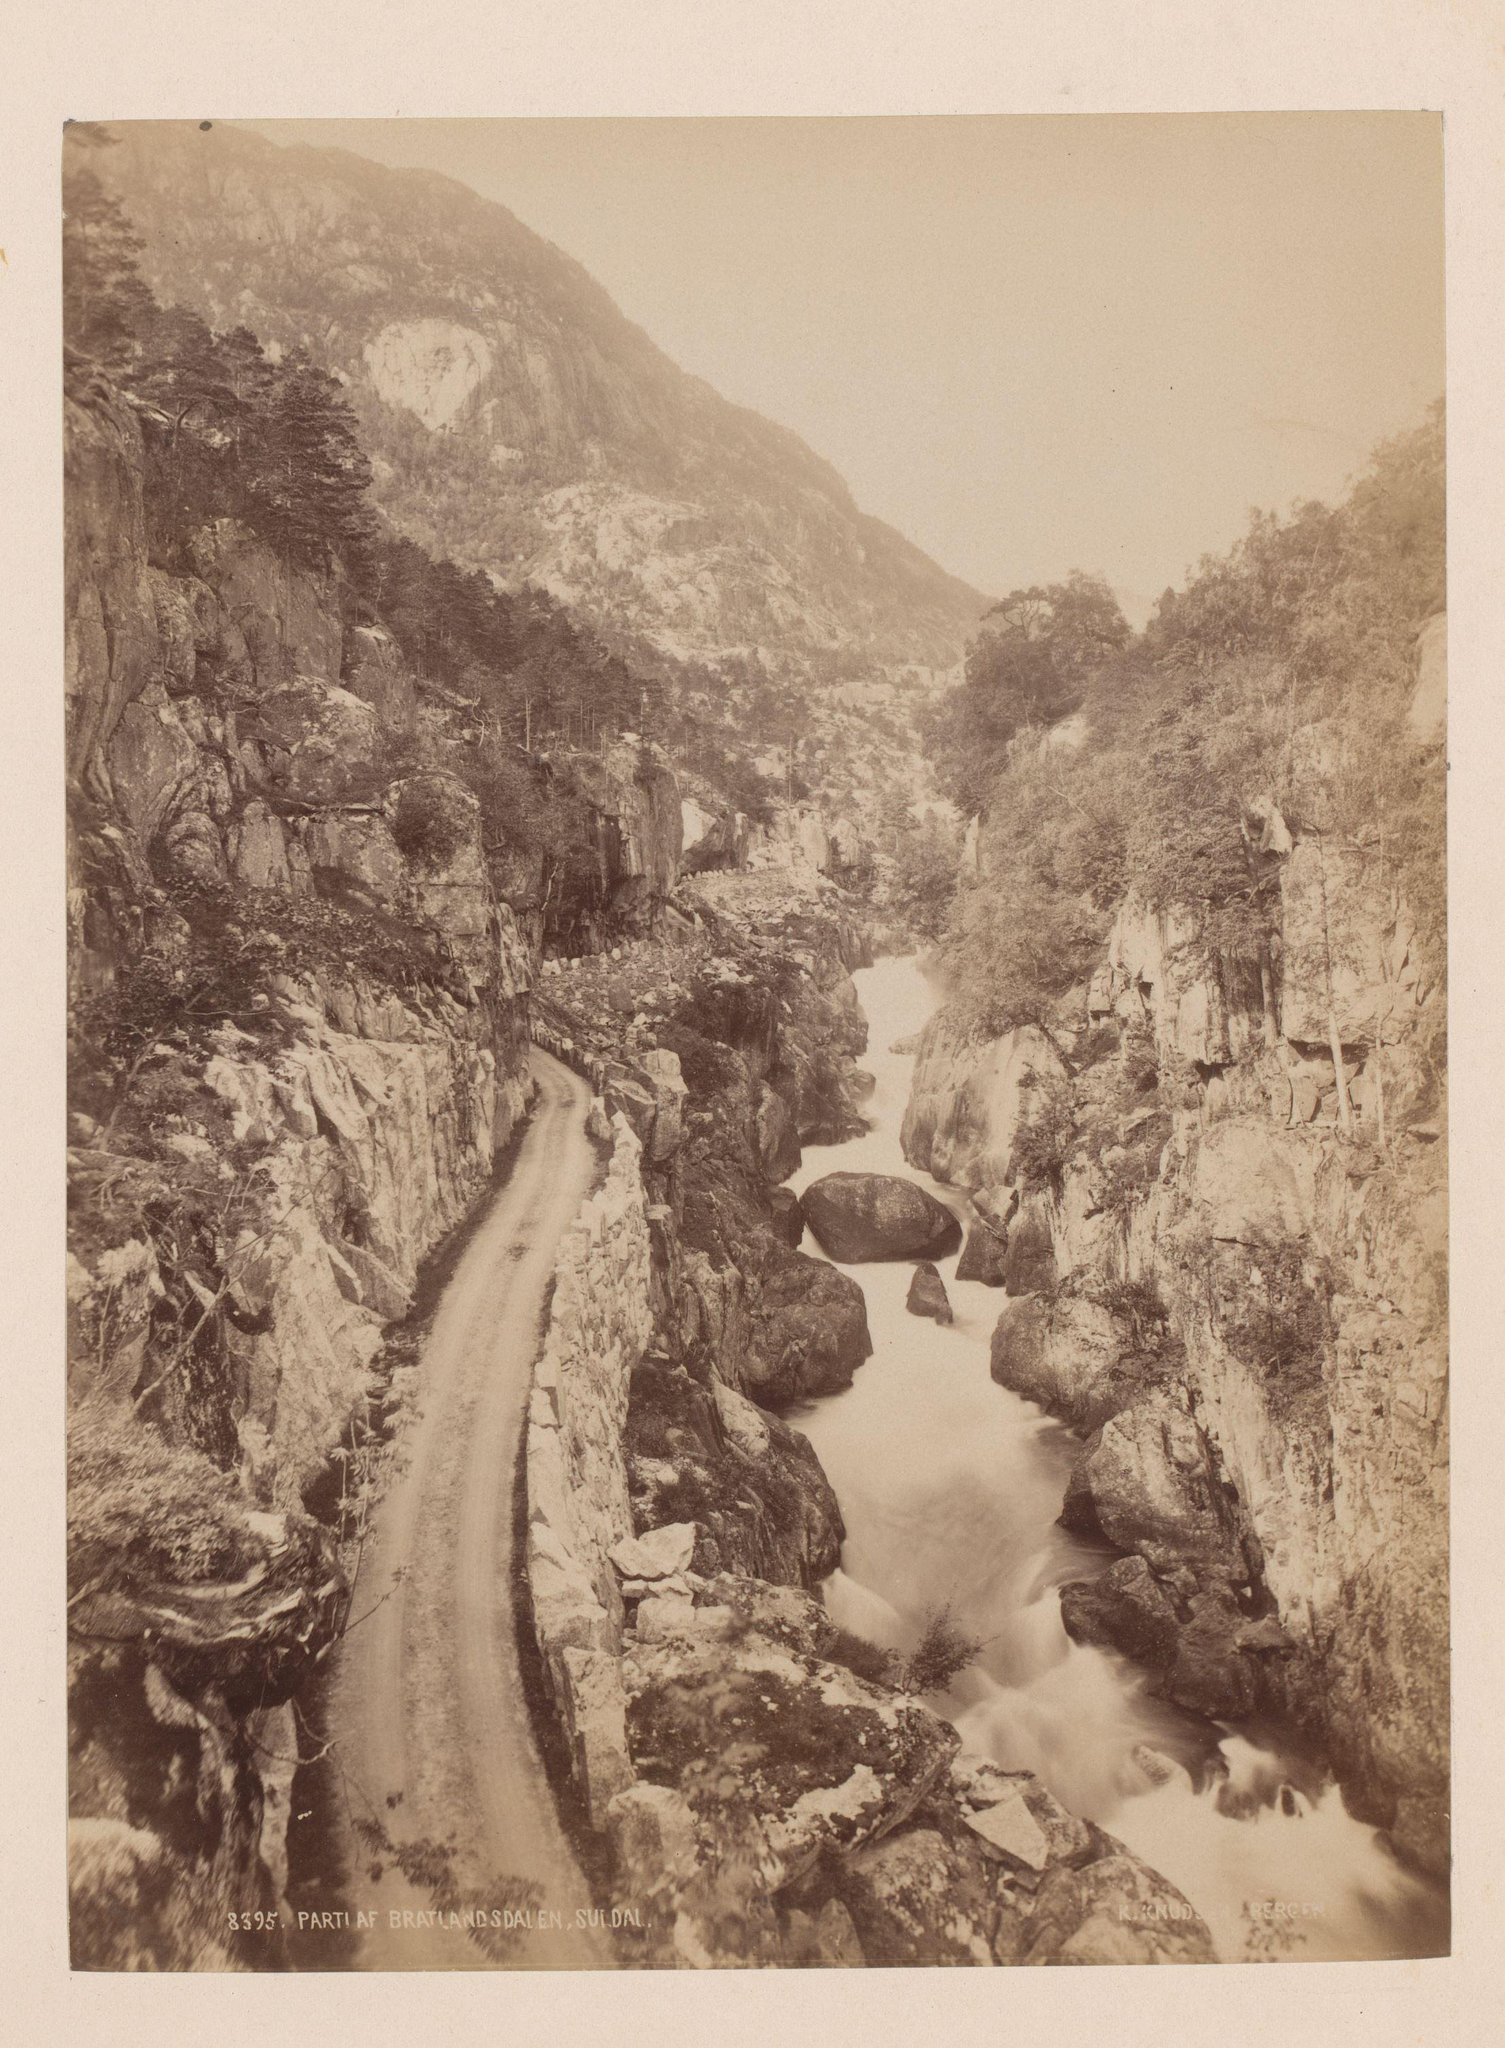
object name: photograph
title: Parti fra Bratlandsdalen, Suldal, Noorwegen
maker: knud knudsen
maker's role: fotograaf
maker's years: 1832-1915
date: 1870-1900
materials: cardboard, photographic support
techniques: albumen print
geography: norway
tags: norway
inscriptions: number: ‘K. Knudsen, Bergen’, caption: ‘3375 PARTI FRA BRATLANDSDALEN SULDAL’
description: Bergweg van boven af gezien, met rechts daarvan een wild stromende rivier. Er zijn geen mensen afgebeeld. Suldal is een gemeente in de Noorse provincie Rogaland.